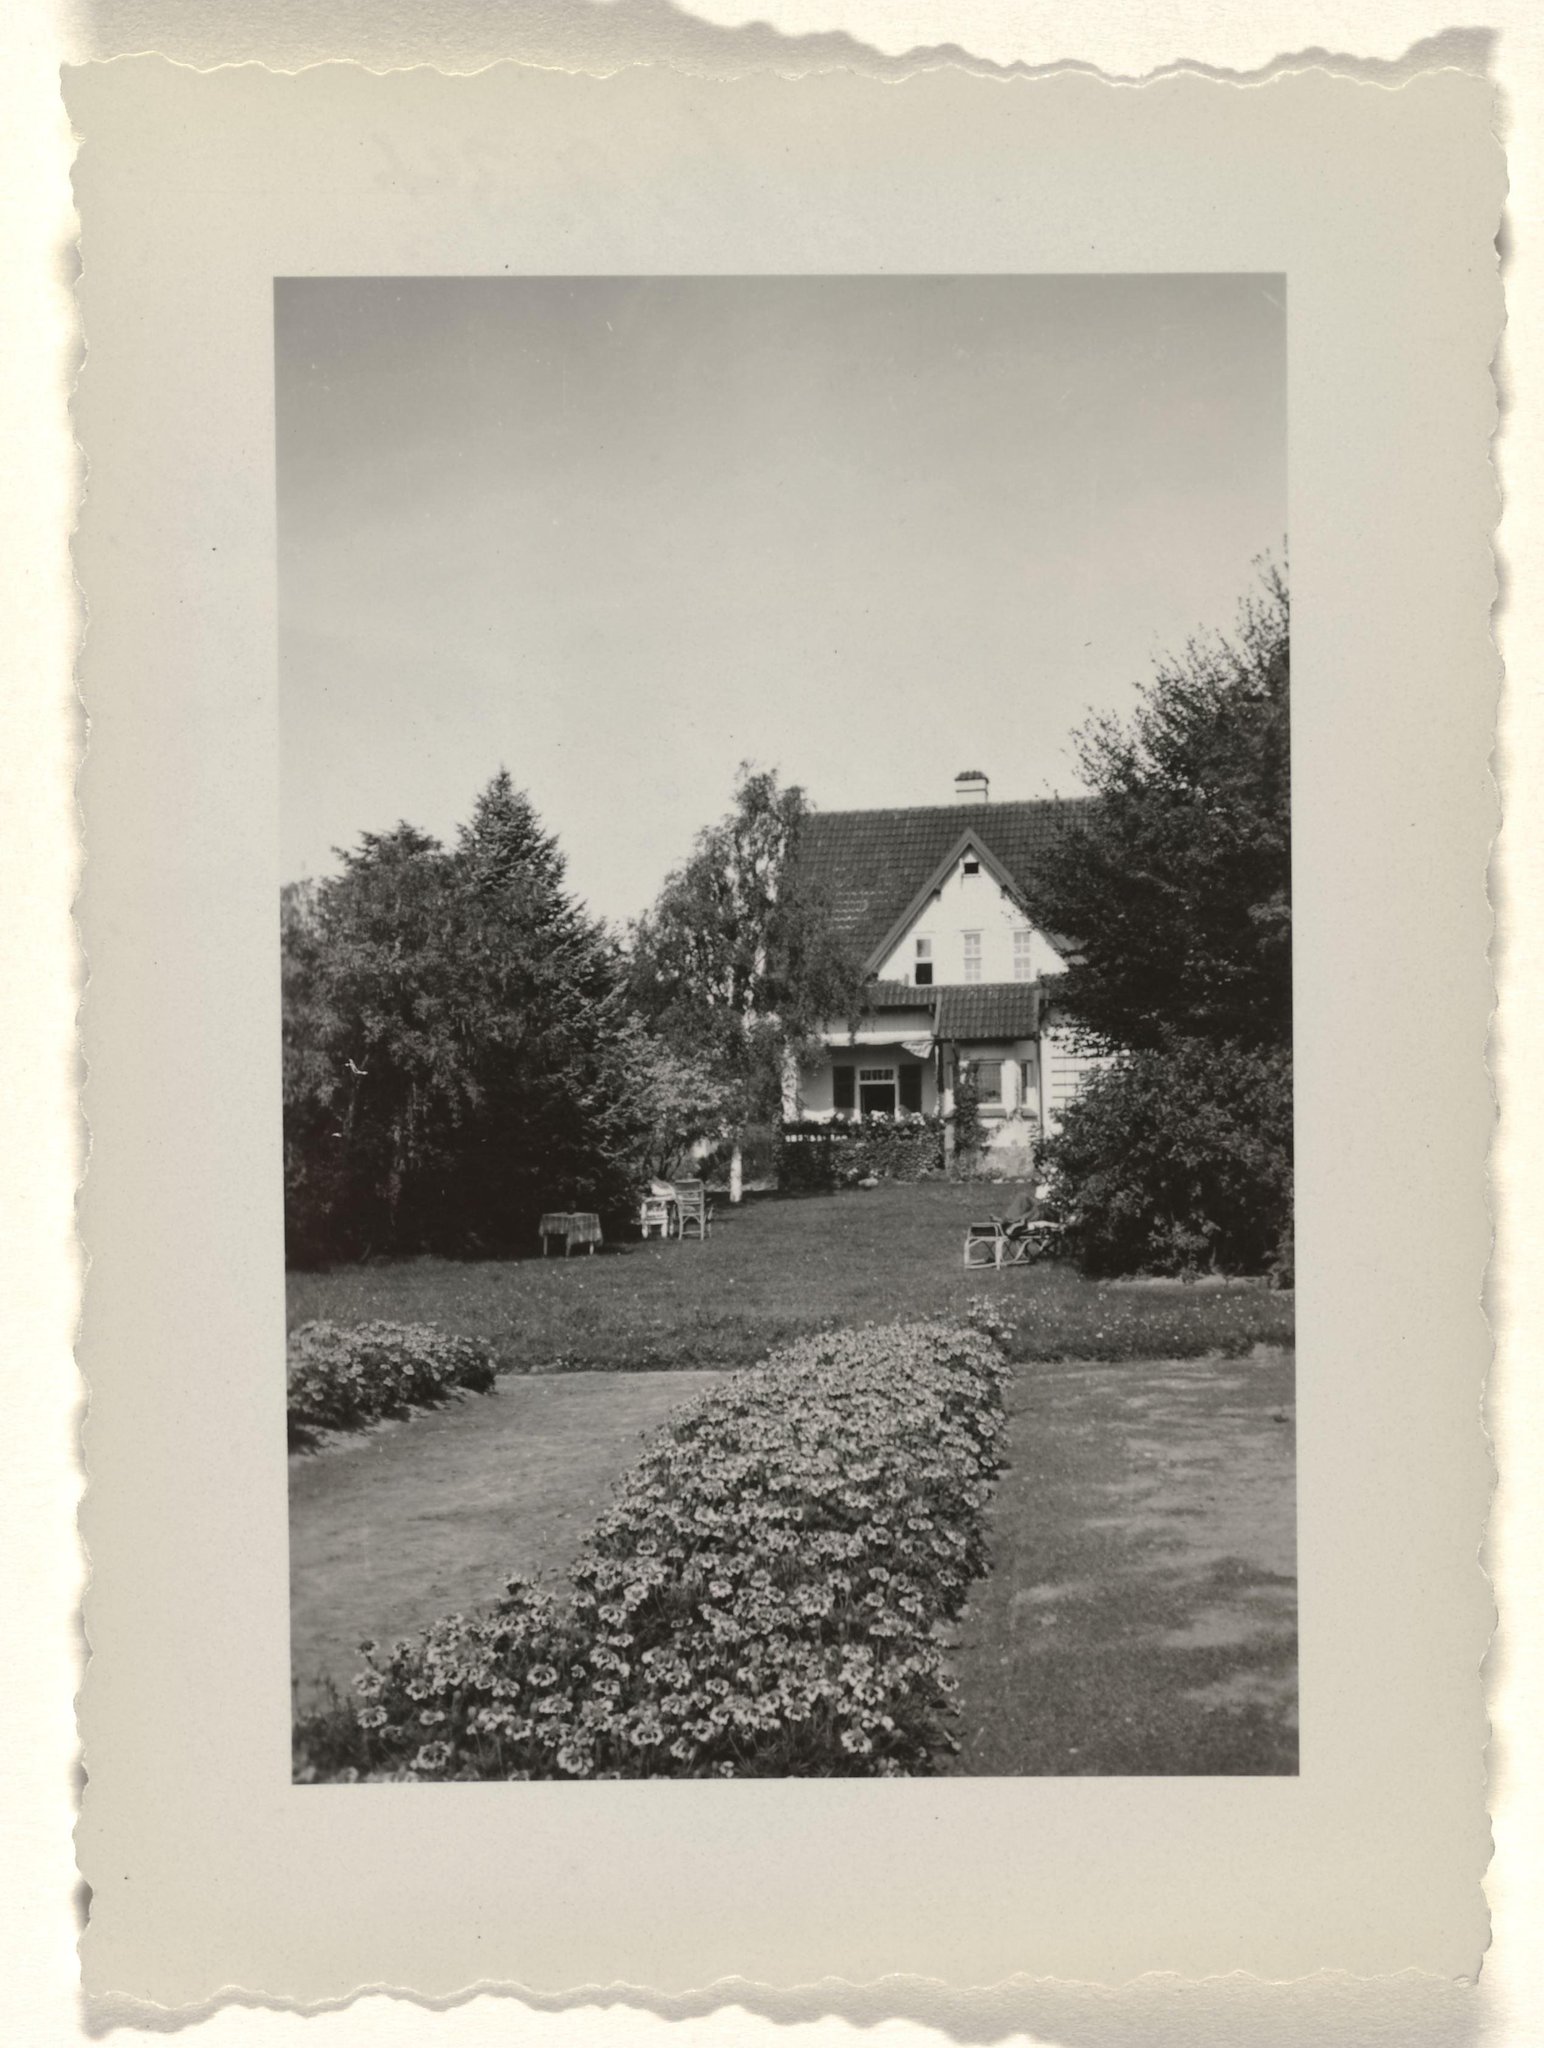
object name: photograph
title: Huis Fahrenkamp, van een afstand bekeken, met een gazon, een struikenhaag en bomen op de voorgrond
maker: Anonymous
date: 1934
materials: photographic support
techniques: gelatin silver print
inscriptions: date: ‘6.9.34. ... besonders ... ... Aufnahme von Haus u. Garten Fahrenkamp’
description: Zicht op huis Fahrenkamp, van een afstand bekeken, met een gazon, een struikenhaag en bomen op de voorgrond.